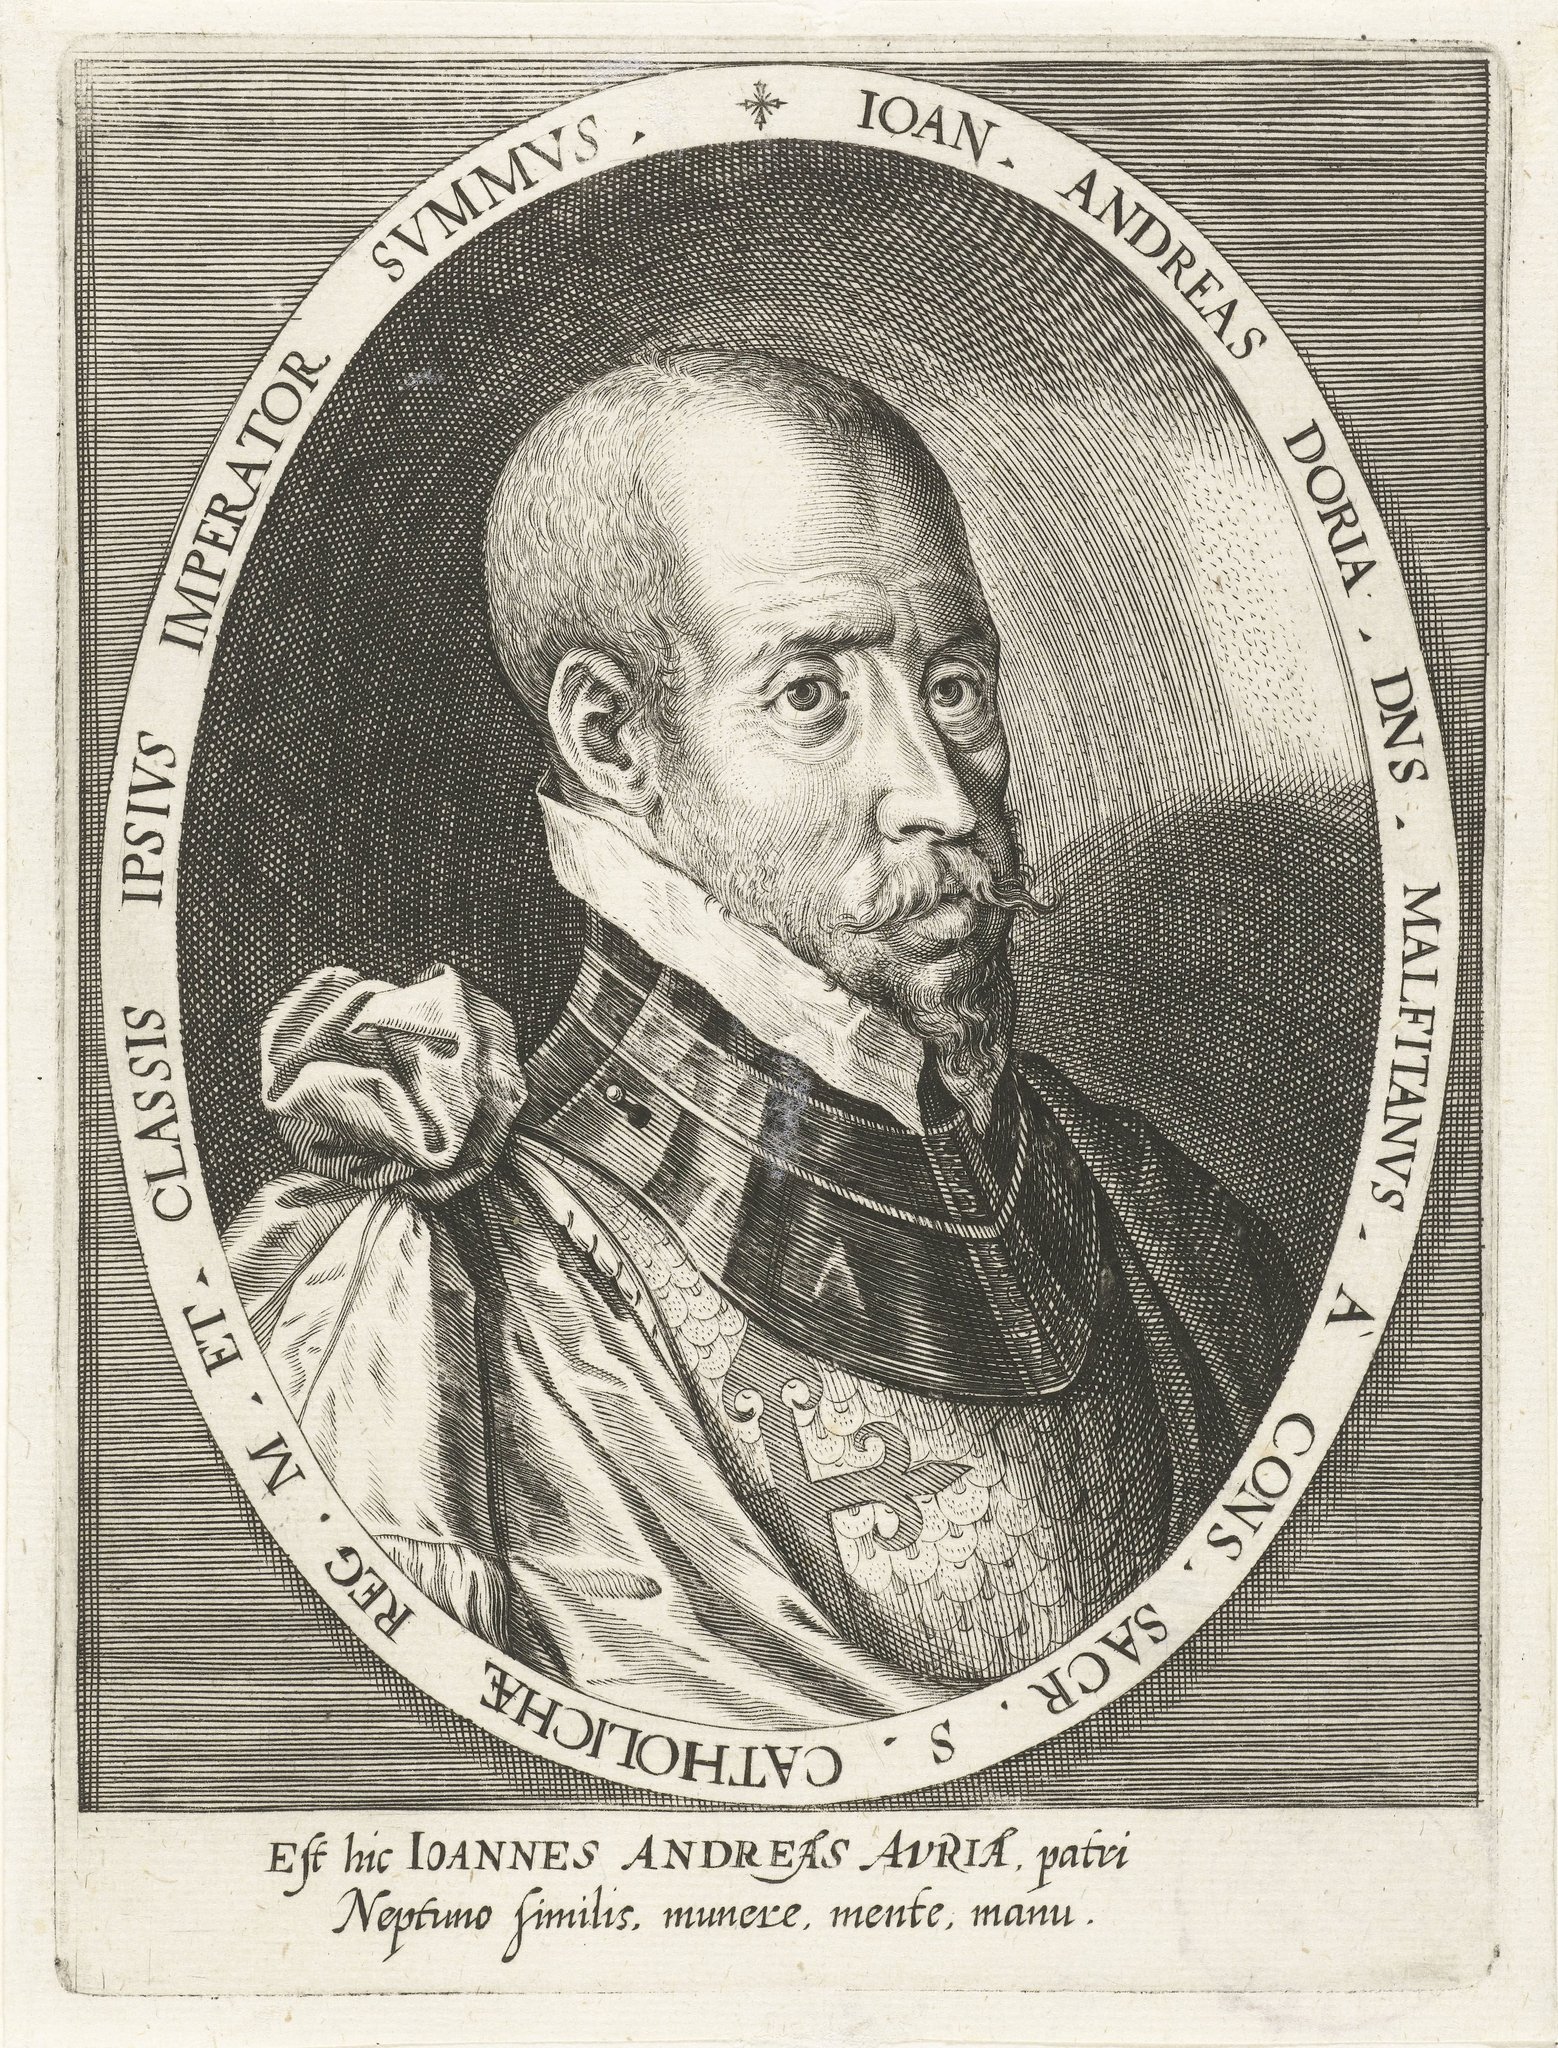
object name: print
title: Portret van admiraal Giovanni Andrea Doria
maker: dominicus custos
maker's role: print maker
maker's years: 1560-1615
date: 1600-1604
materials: paper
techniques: engraving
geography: augsburg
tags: admiraal, giovanni andrea doria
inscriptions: collector's mark: Lugt 240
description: Illustratie uit: D. Custos en M. Henning. Atrium heroicum Caesarum, regum aliorq. summatum ac procerum qui intra proximum seculum vixere, aut hodie supersunt, imaginib. Deel 1-4. Augsburg: D. Custos, 1600-1604.